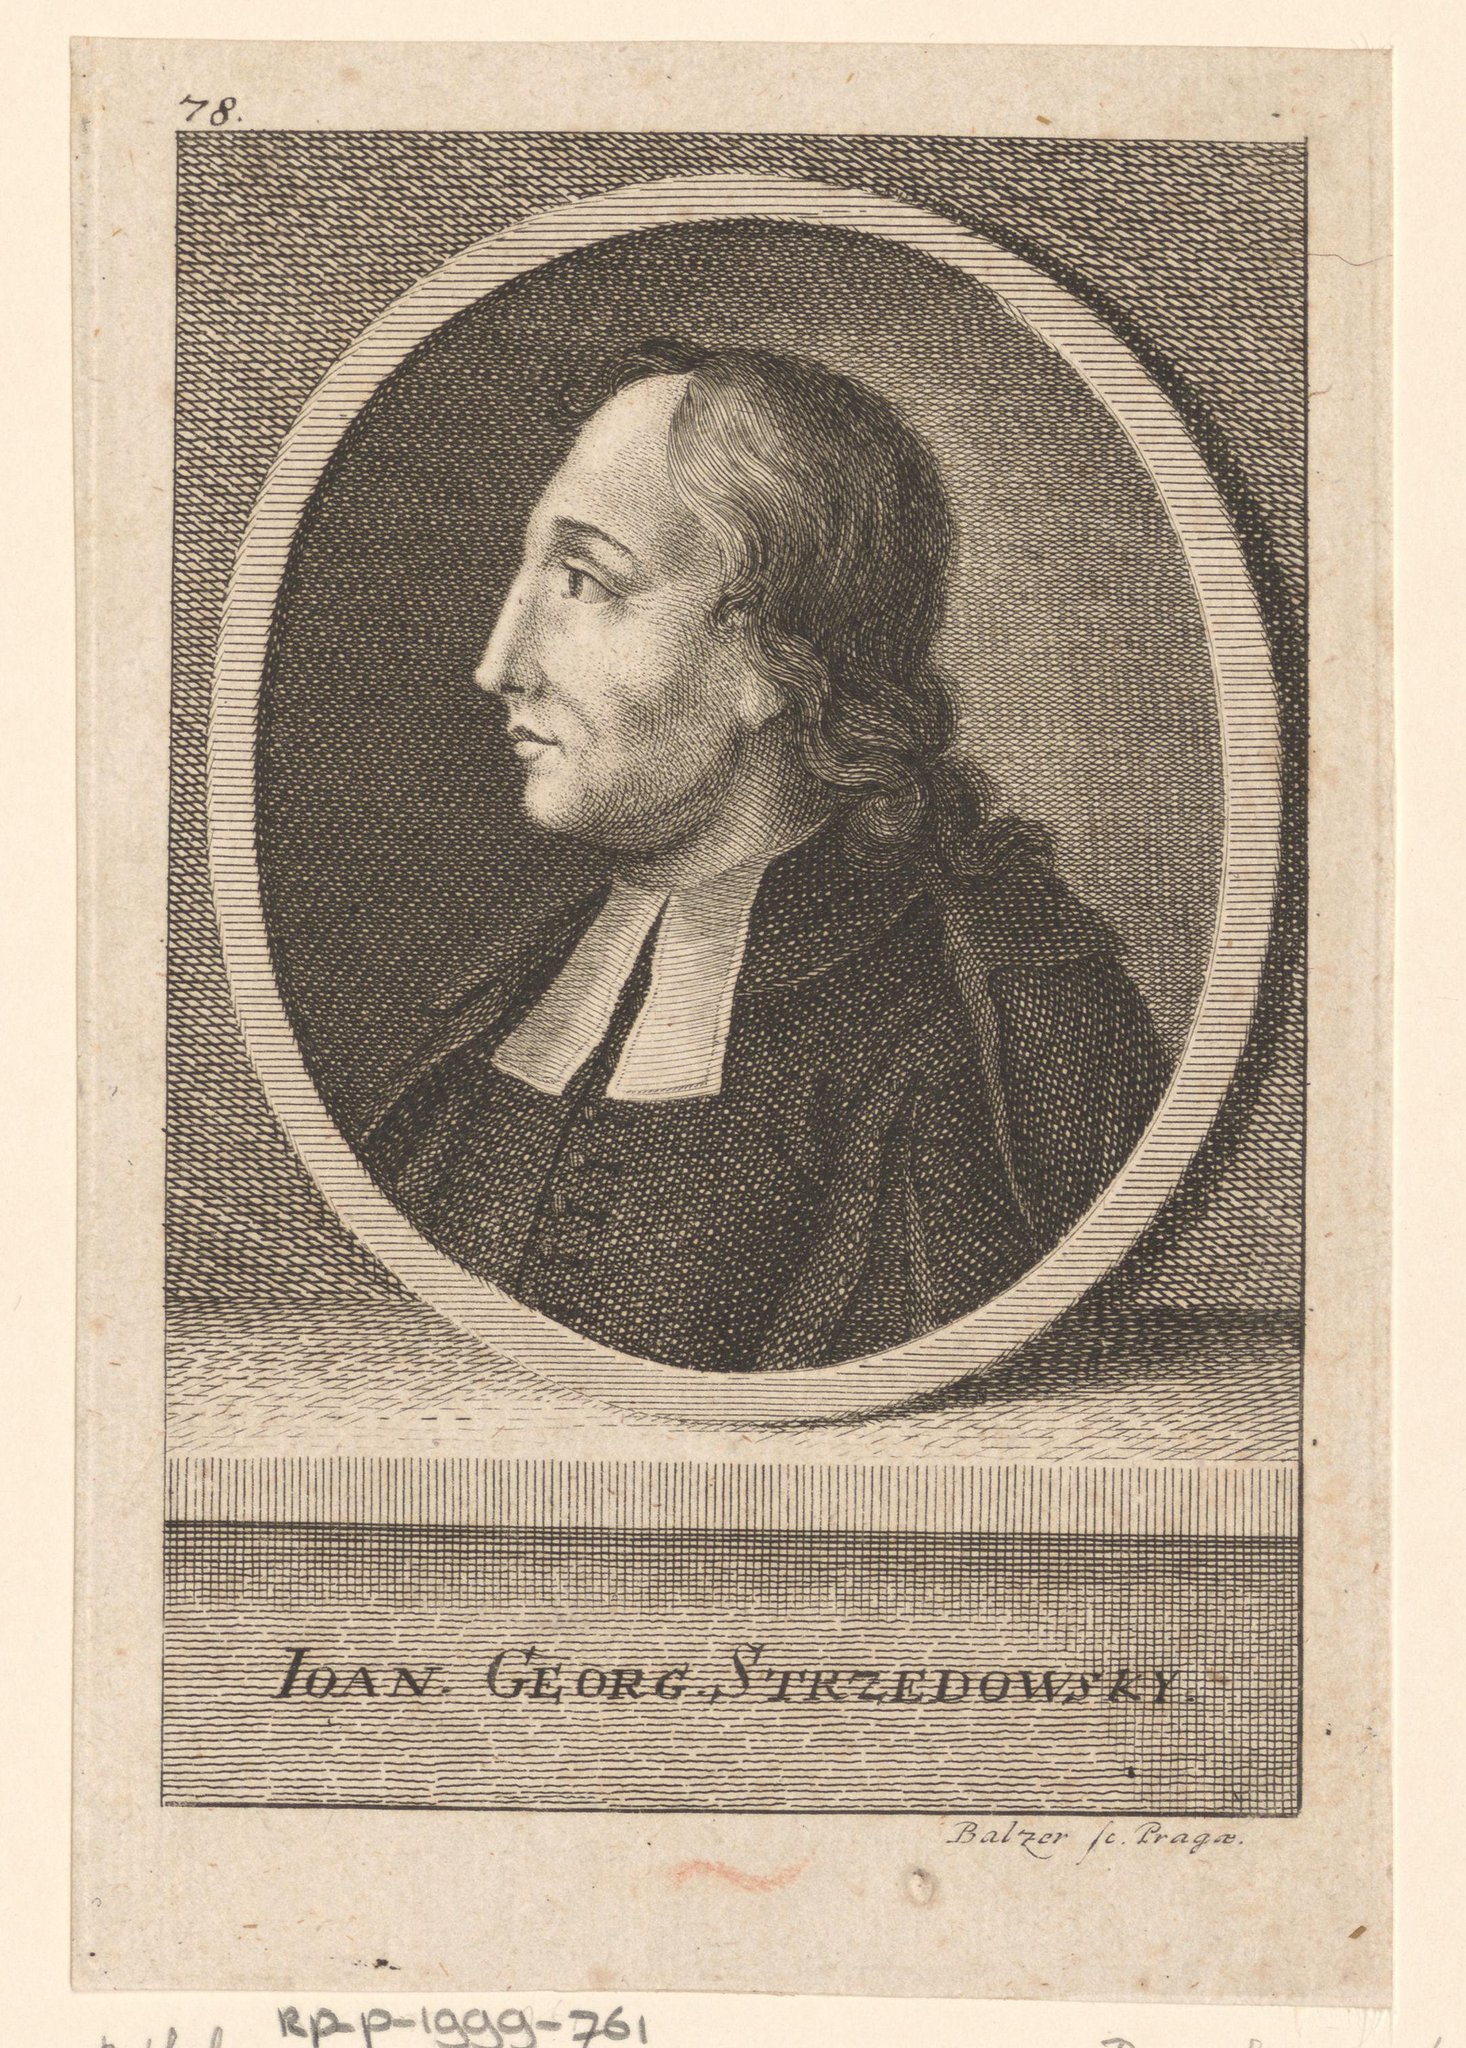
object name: print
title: Portret Johann Georg Strzedowsky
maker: jan balzer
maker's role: print maker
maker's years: 1736-1799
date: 1748-1799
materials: paper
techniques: engraving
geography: prague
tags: theologian, historical persons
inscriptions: collector's mark: Lugt 2228, collector's mark: Lugt 2710